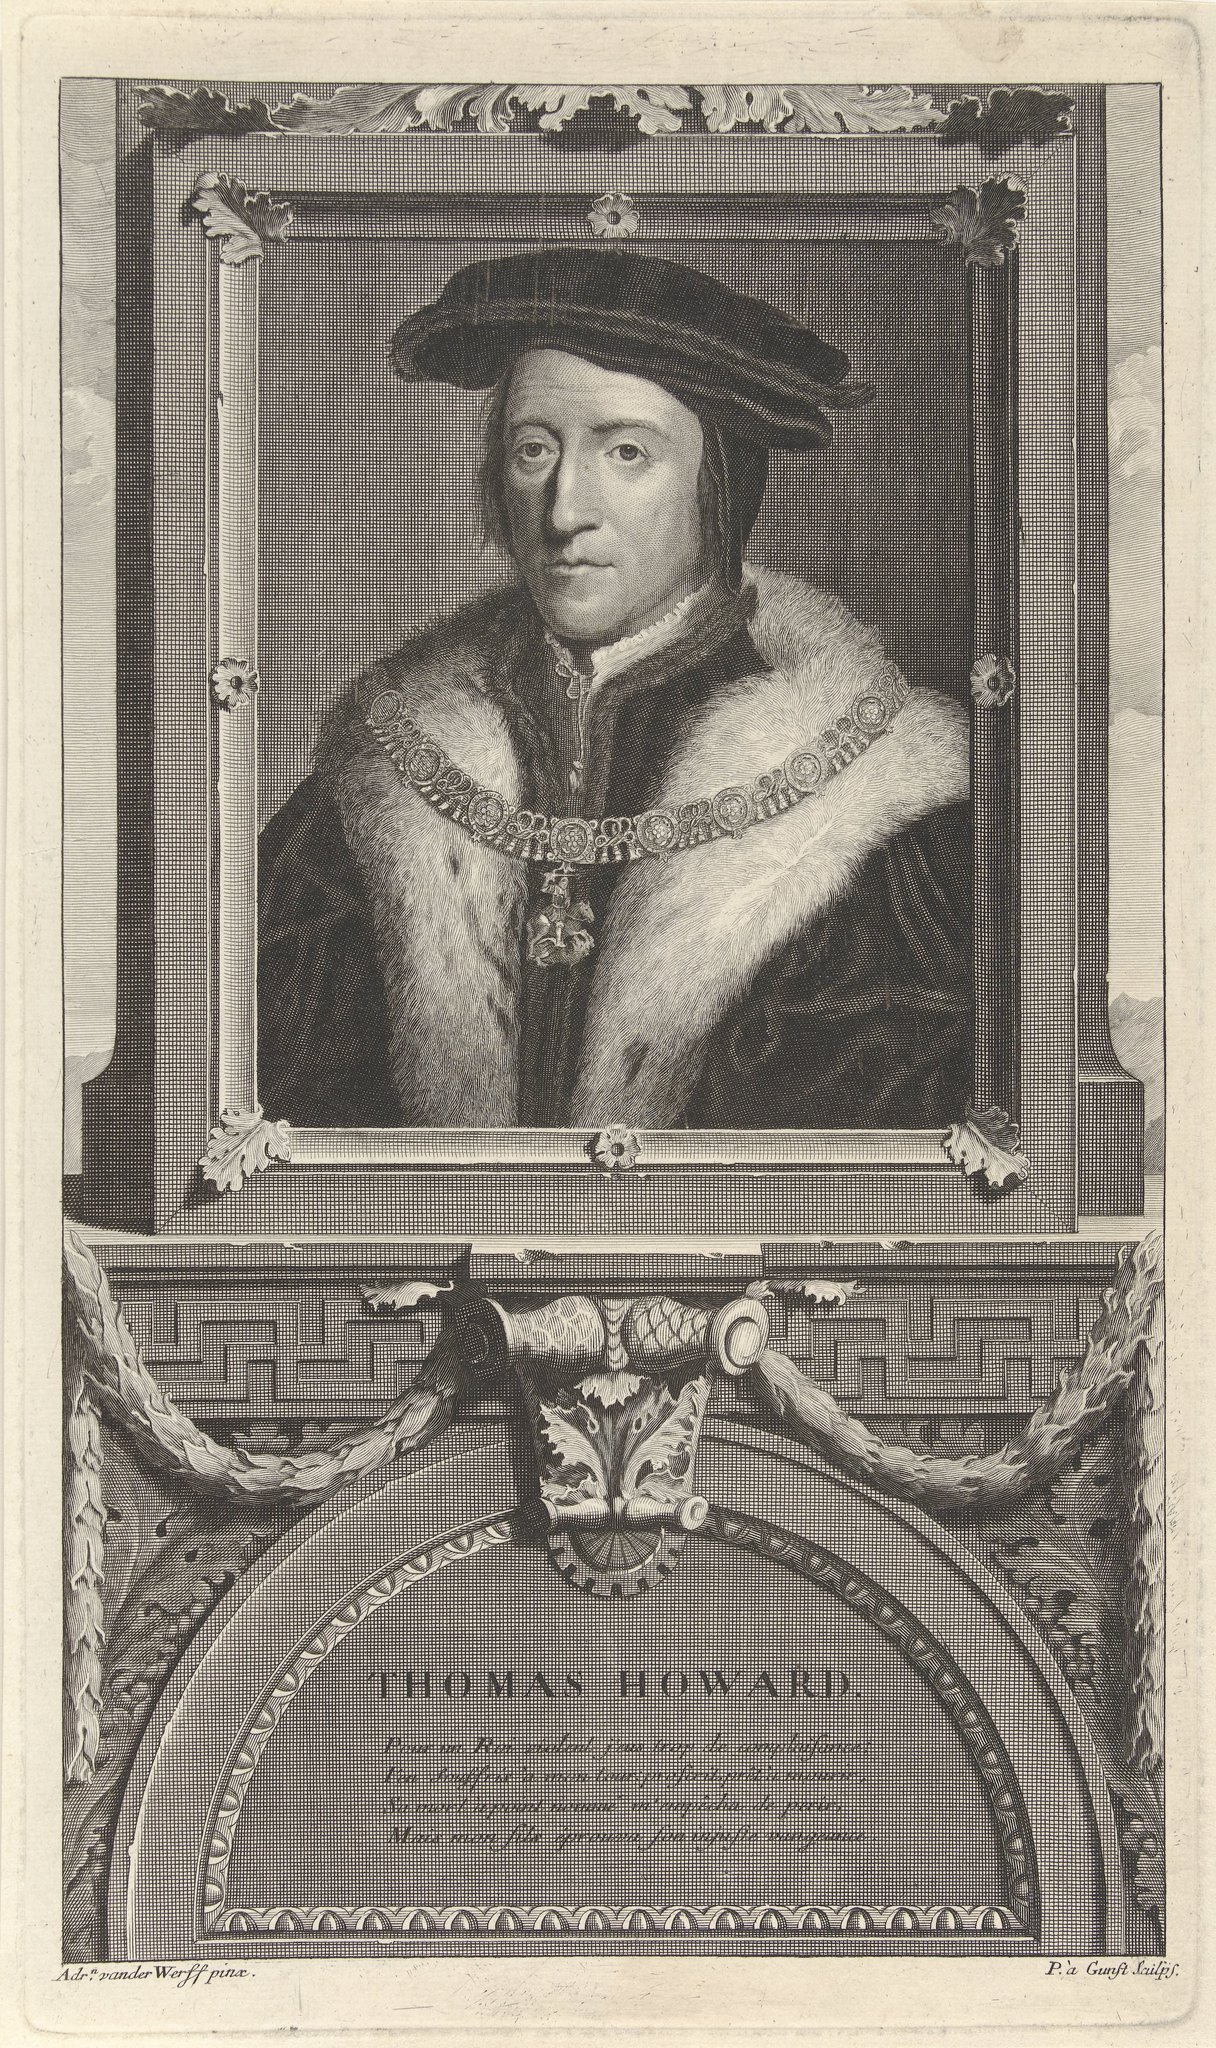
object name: print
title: Portret van Thomas Howard, graaf van Norfolk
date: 1669-1731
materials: paper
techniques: engraving, etching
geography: amsterdam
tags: politician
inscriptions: collector's mark: Lugt 2228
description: Thomas Howard, graaf van Norfolk en voorzitter van de koninklijke raad van Engeland gedurende de regeringsperiode van Hendrik VIII. De prent heeft als onderschrift een Frans gedicht over zijn relatie met Hendrik VIII.